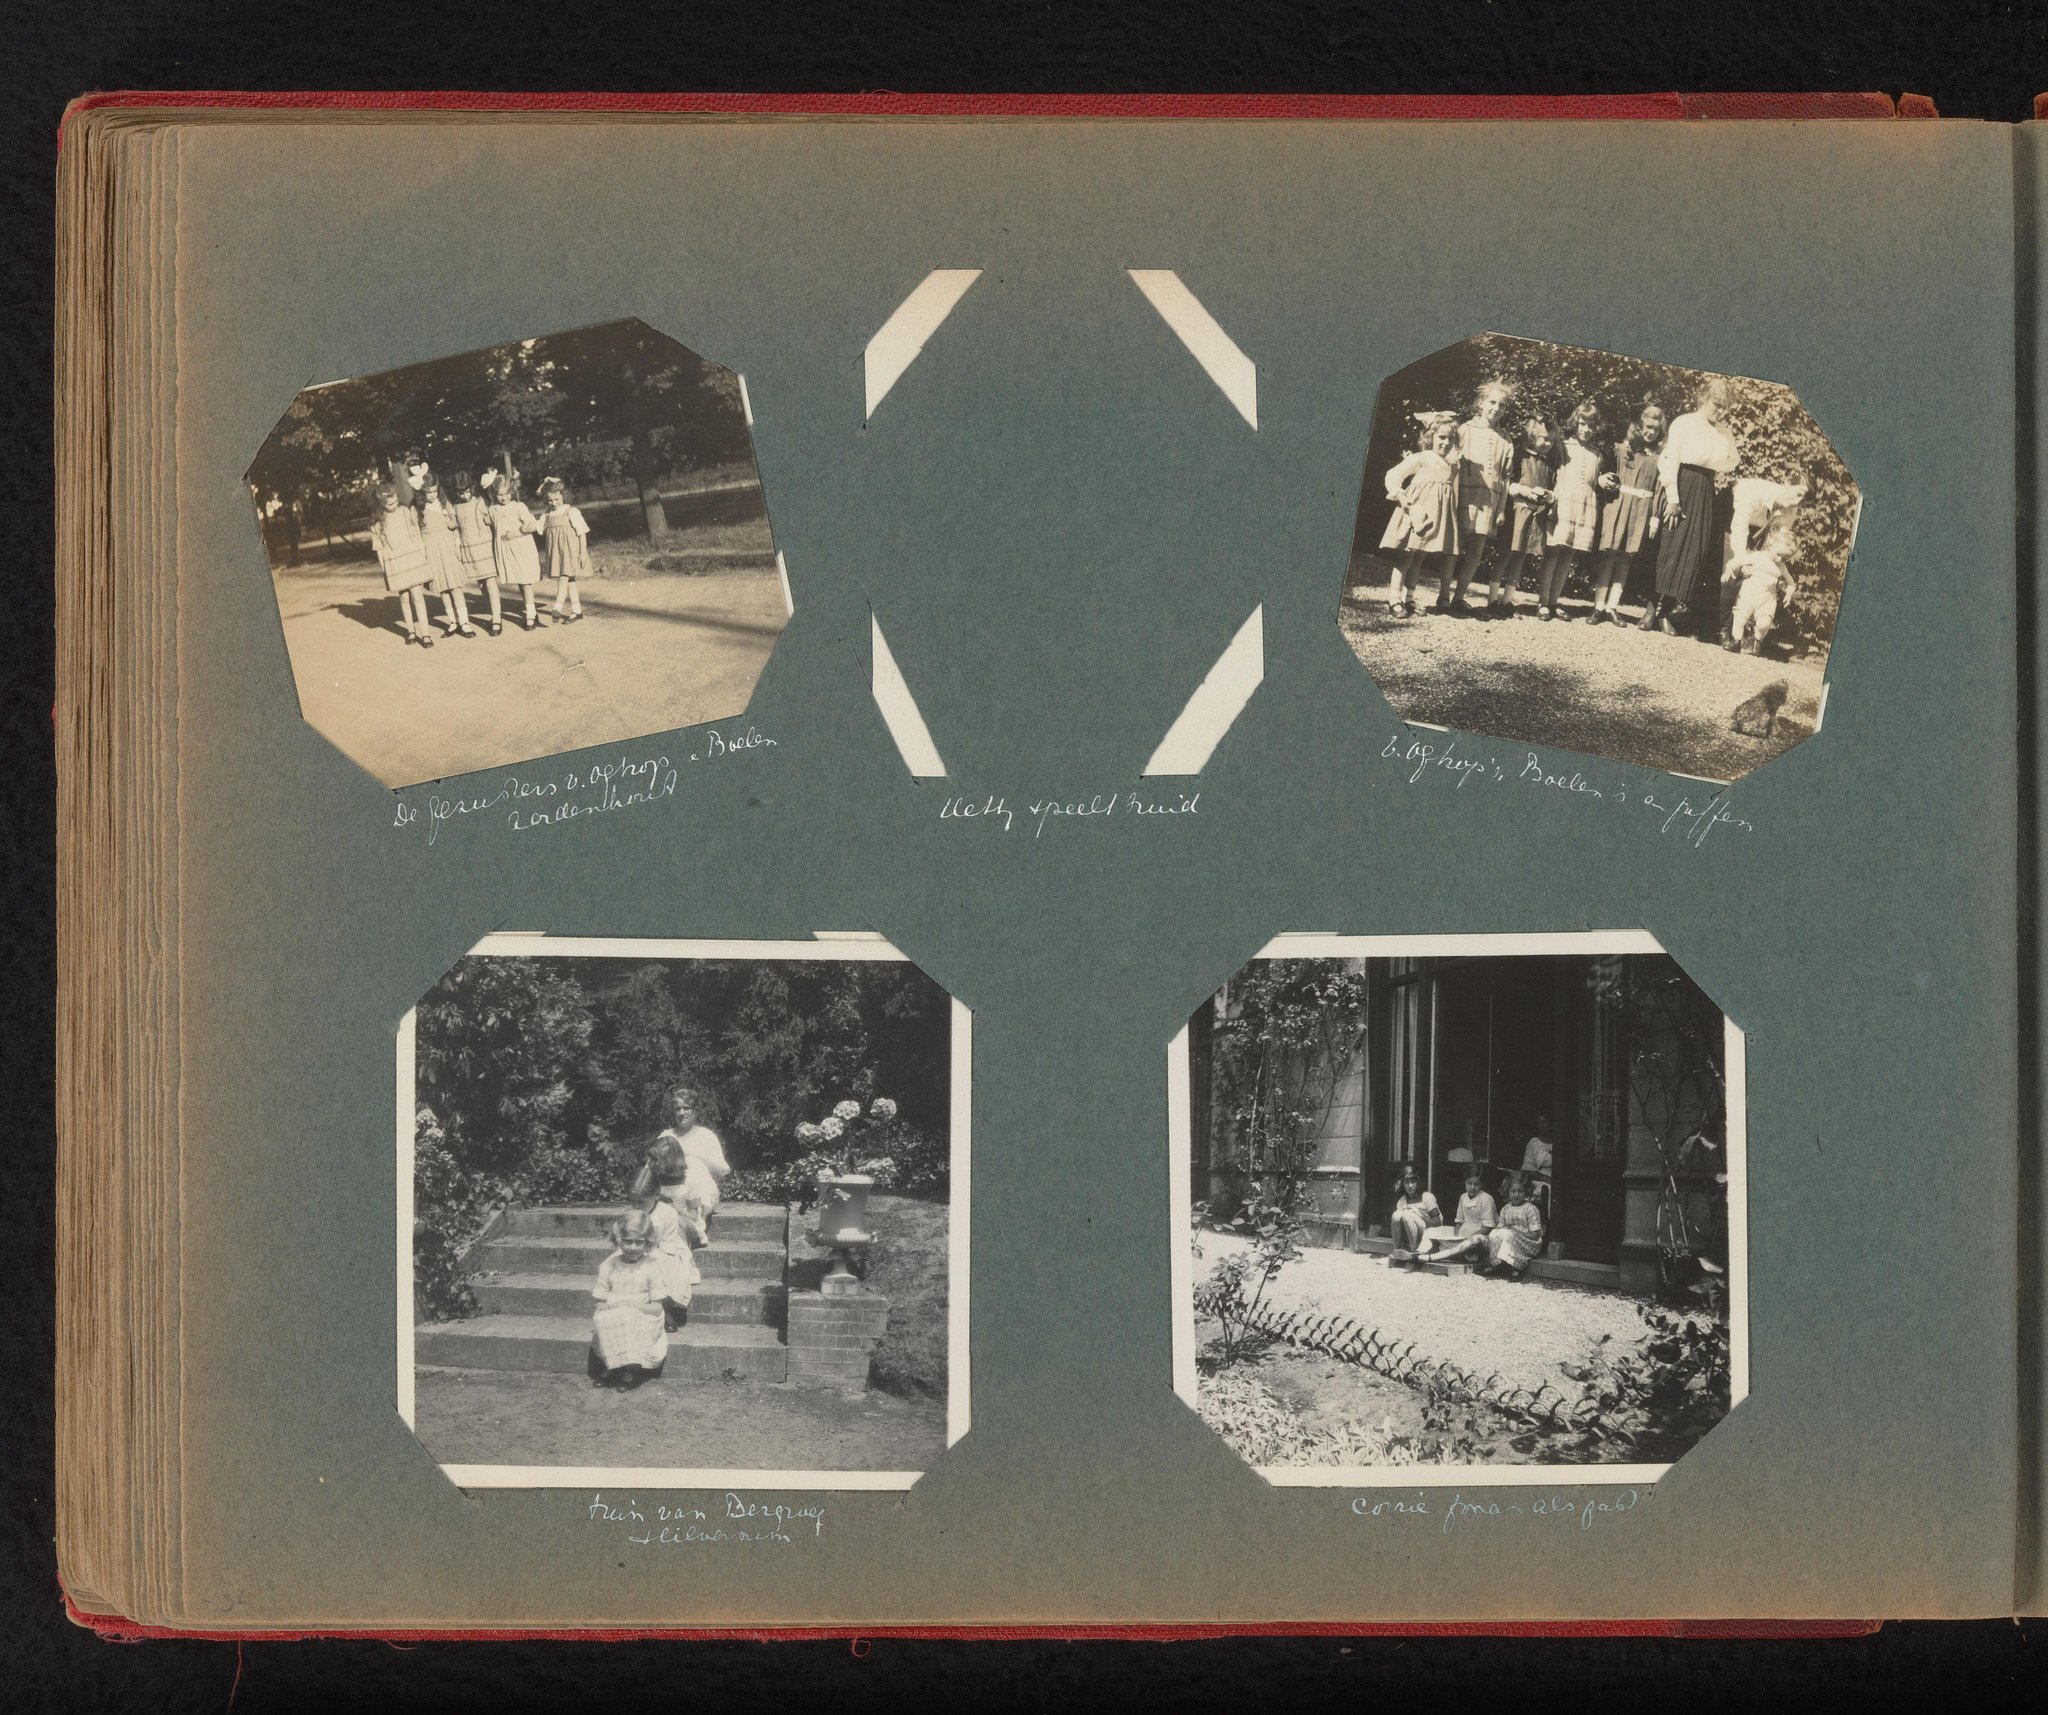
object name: album leaf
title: Kinderen, waaronder Eva en Hetty Boelen, in een park in Aerdenhout en een tuin in Hilversum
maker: charlotte alida boelen-matthes (lot)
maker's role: amateurfotograaf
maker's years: 1889-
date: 1920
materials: paper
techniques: gelatin silver print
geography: netherlands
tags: amsterdam, eva charlotte pennink-boelen, park, garden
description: Deze foto's zijn onderdeel van een album.